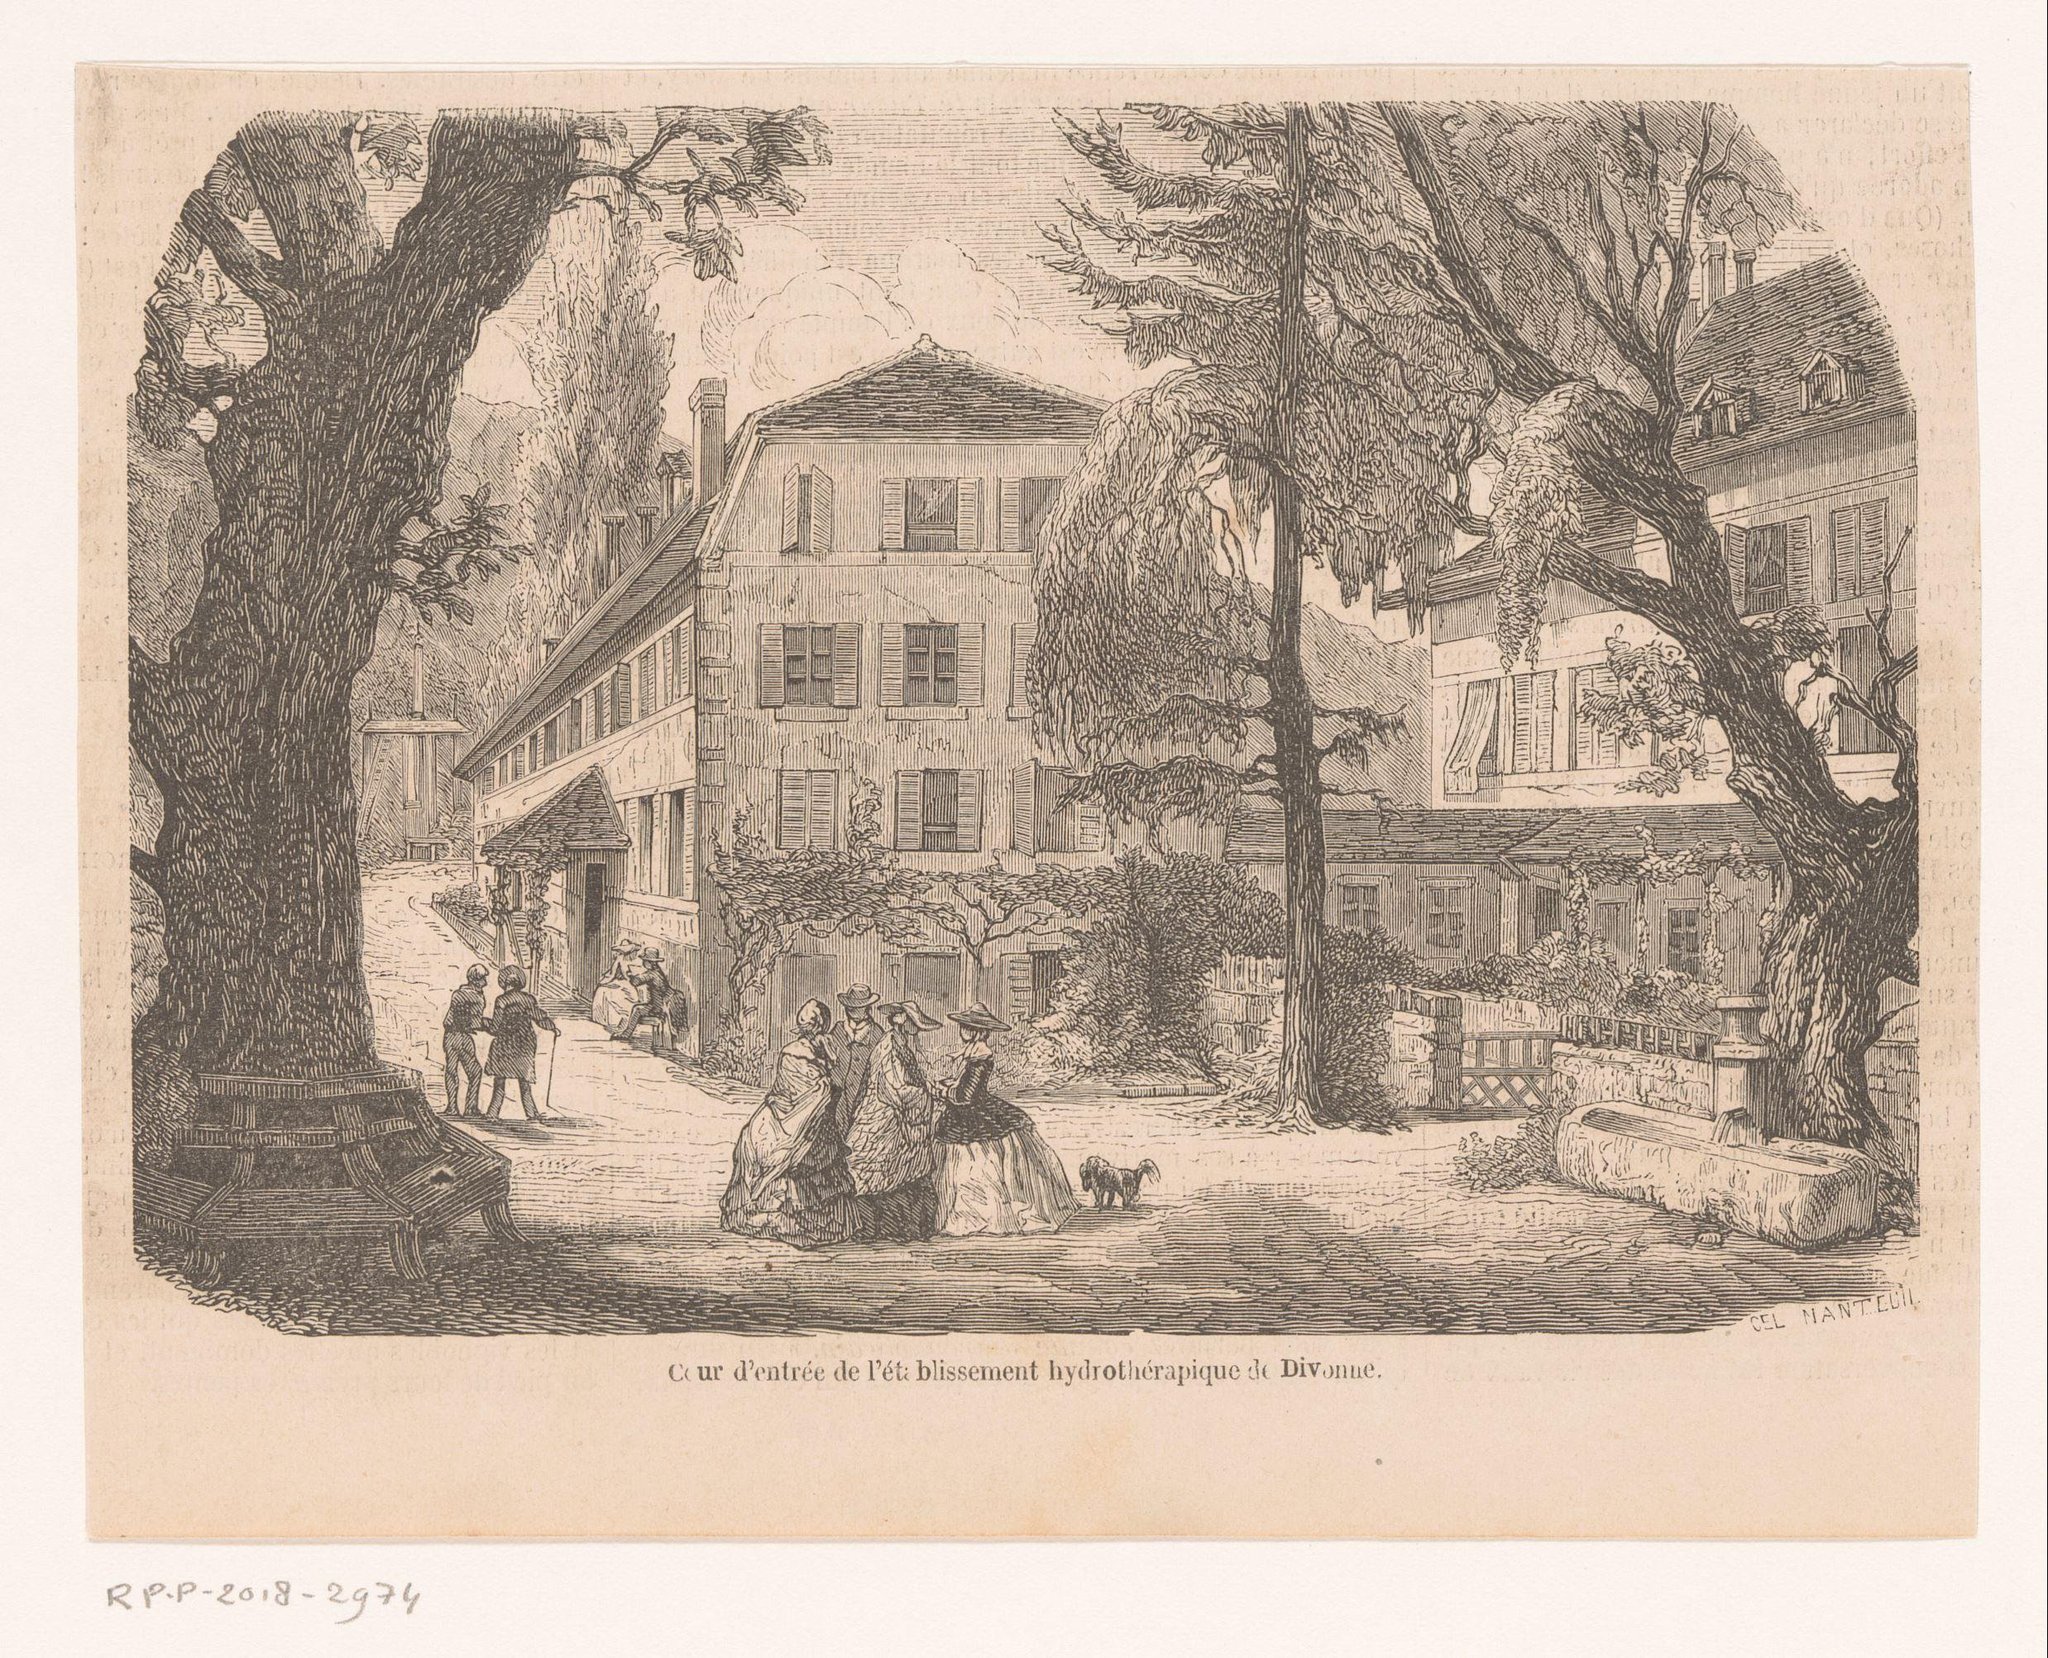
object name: print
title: Ingang van de waterkrachtcentrale in Divonne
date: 1856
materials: paper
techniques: letterpress printing, engraving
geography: paris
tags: village street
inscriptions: inscription: ‘L'Illustration 19 juli 1856’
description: Straatgezicht met de ingang van de waterkrachtcentrale in Divonne.